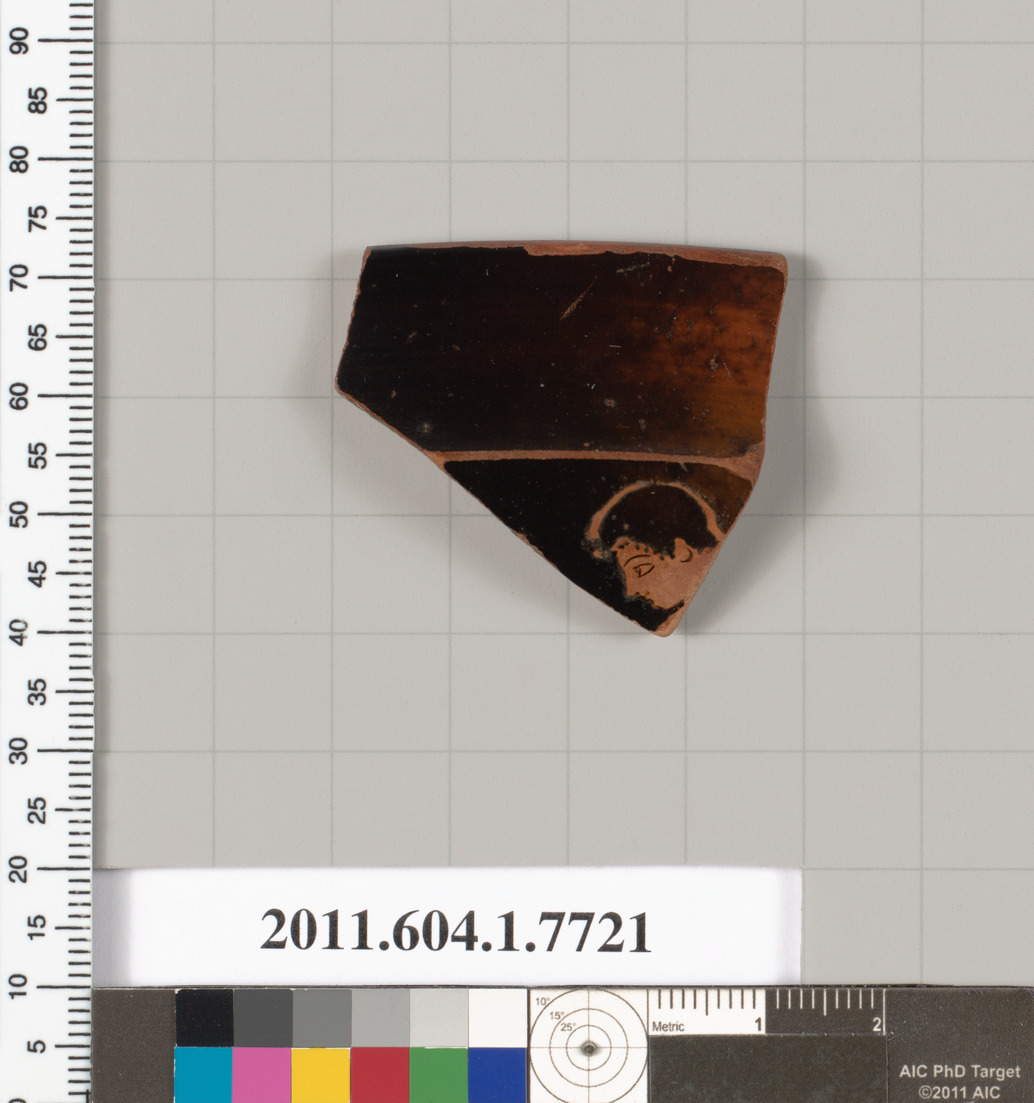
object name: kylix fragment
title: Terracotta rim fragment of a kylix (drinking cup)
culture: greek, attic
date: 460-450 BCE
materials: terracotta